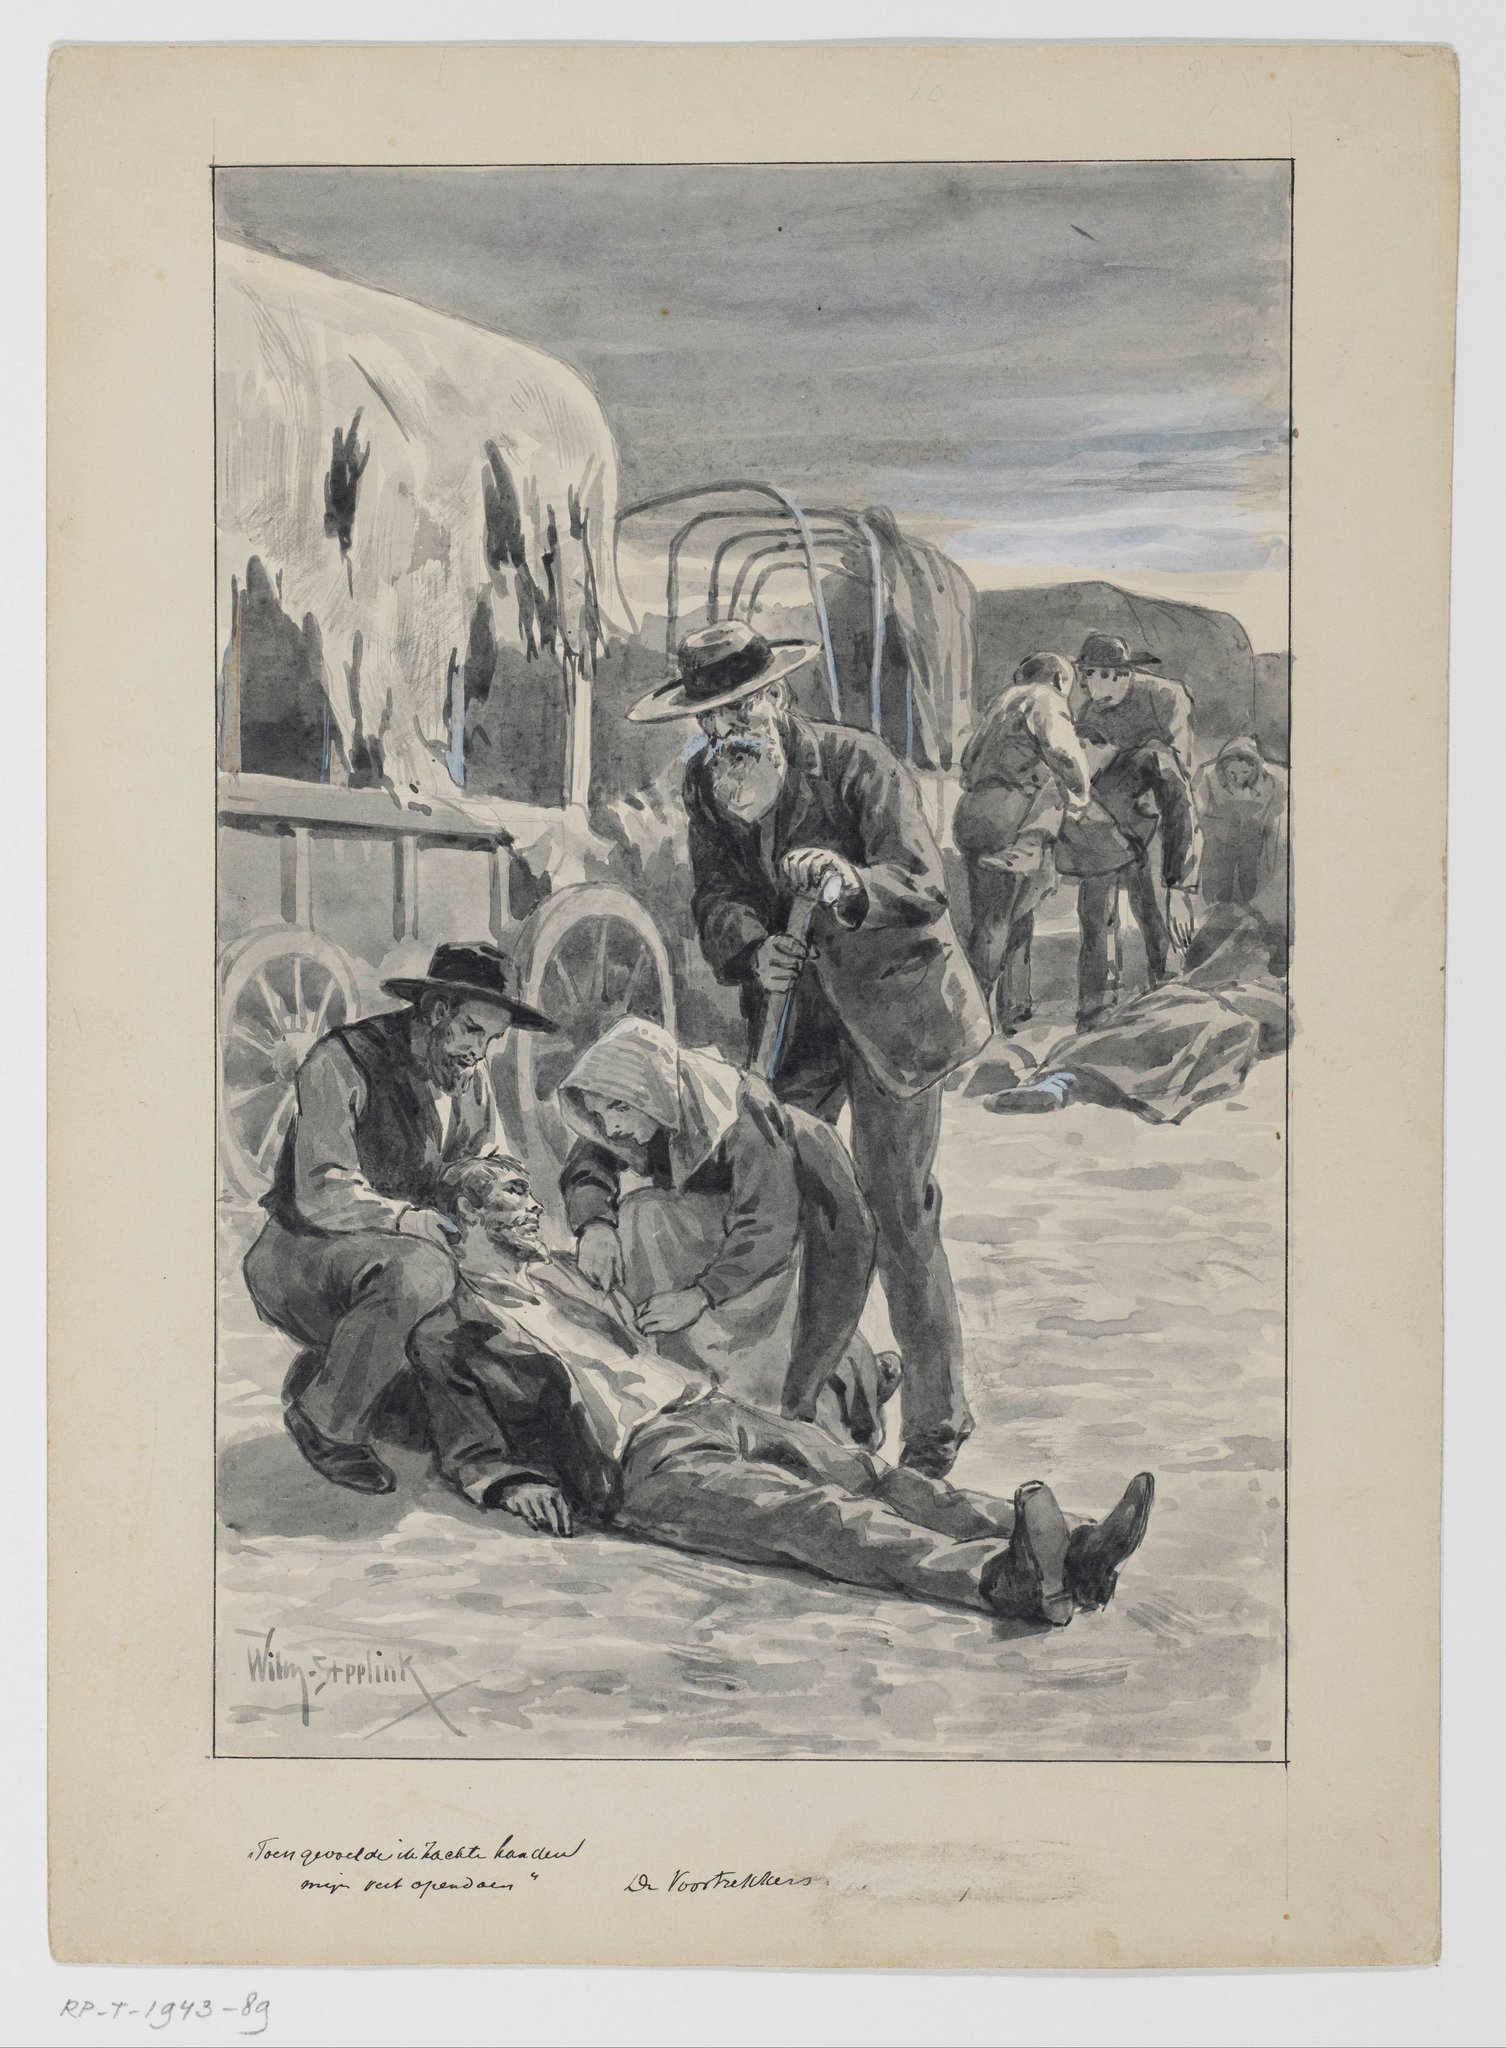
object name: design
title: Gewonde man wordt geholpen door mannen en een vrouw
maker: willem steelink (i)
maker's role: draughtsman, print maker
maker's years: 1826-1913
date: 1836-1913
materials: paper, pencil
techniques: brush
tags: illustration ~ printed matter, book, nursing, tending the sick, violent death, being killed; being mishandled and maltreated; seeking death - ee - death not certain; wounded person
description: Ontwerp voor een illustratie in De Voortrekkers, of Het Dagboek van Izak van der Merwe, door J.D. Kestell en N. Hofmeijer.